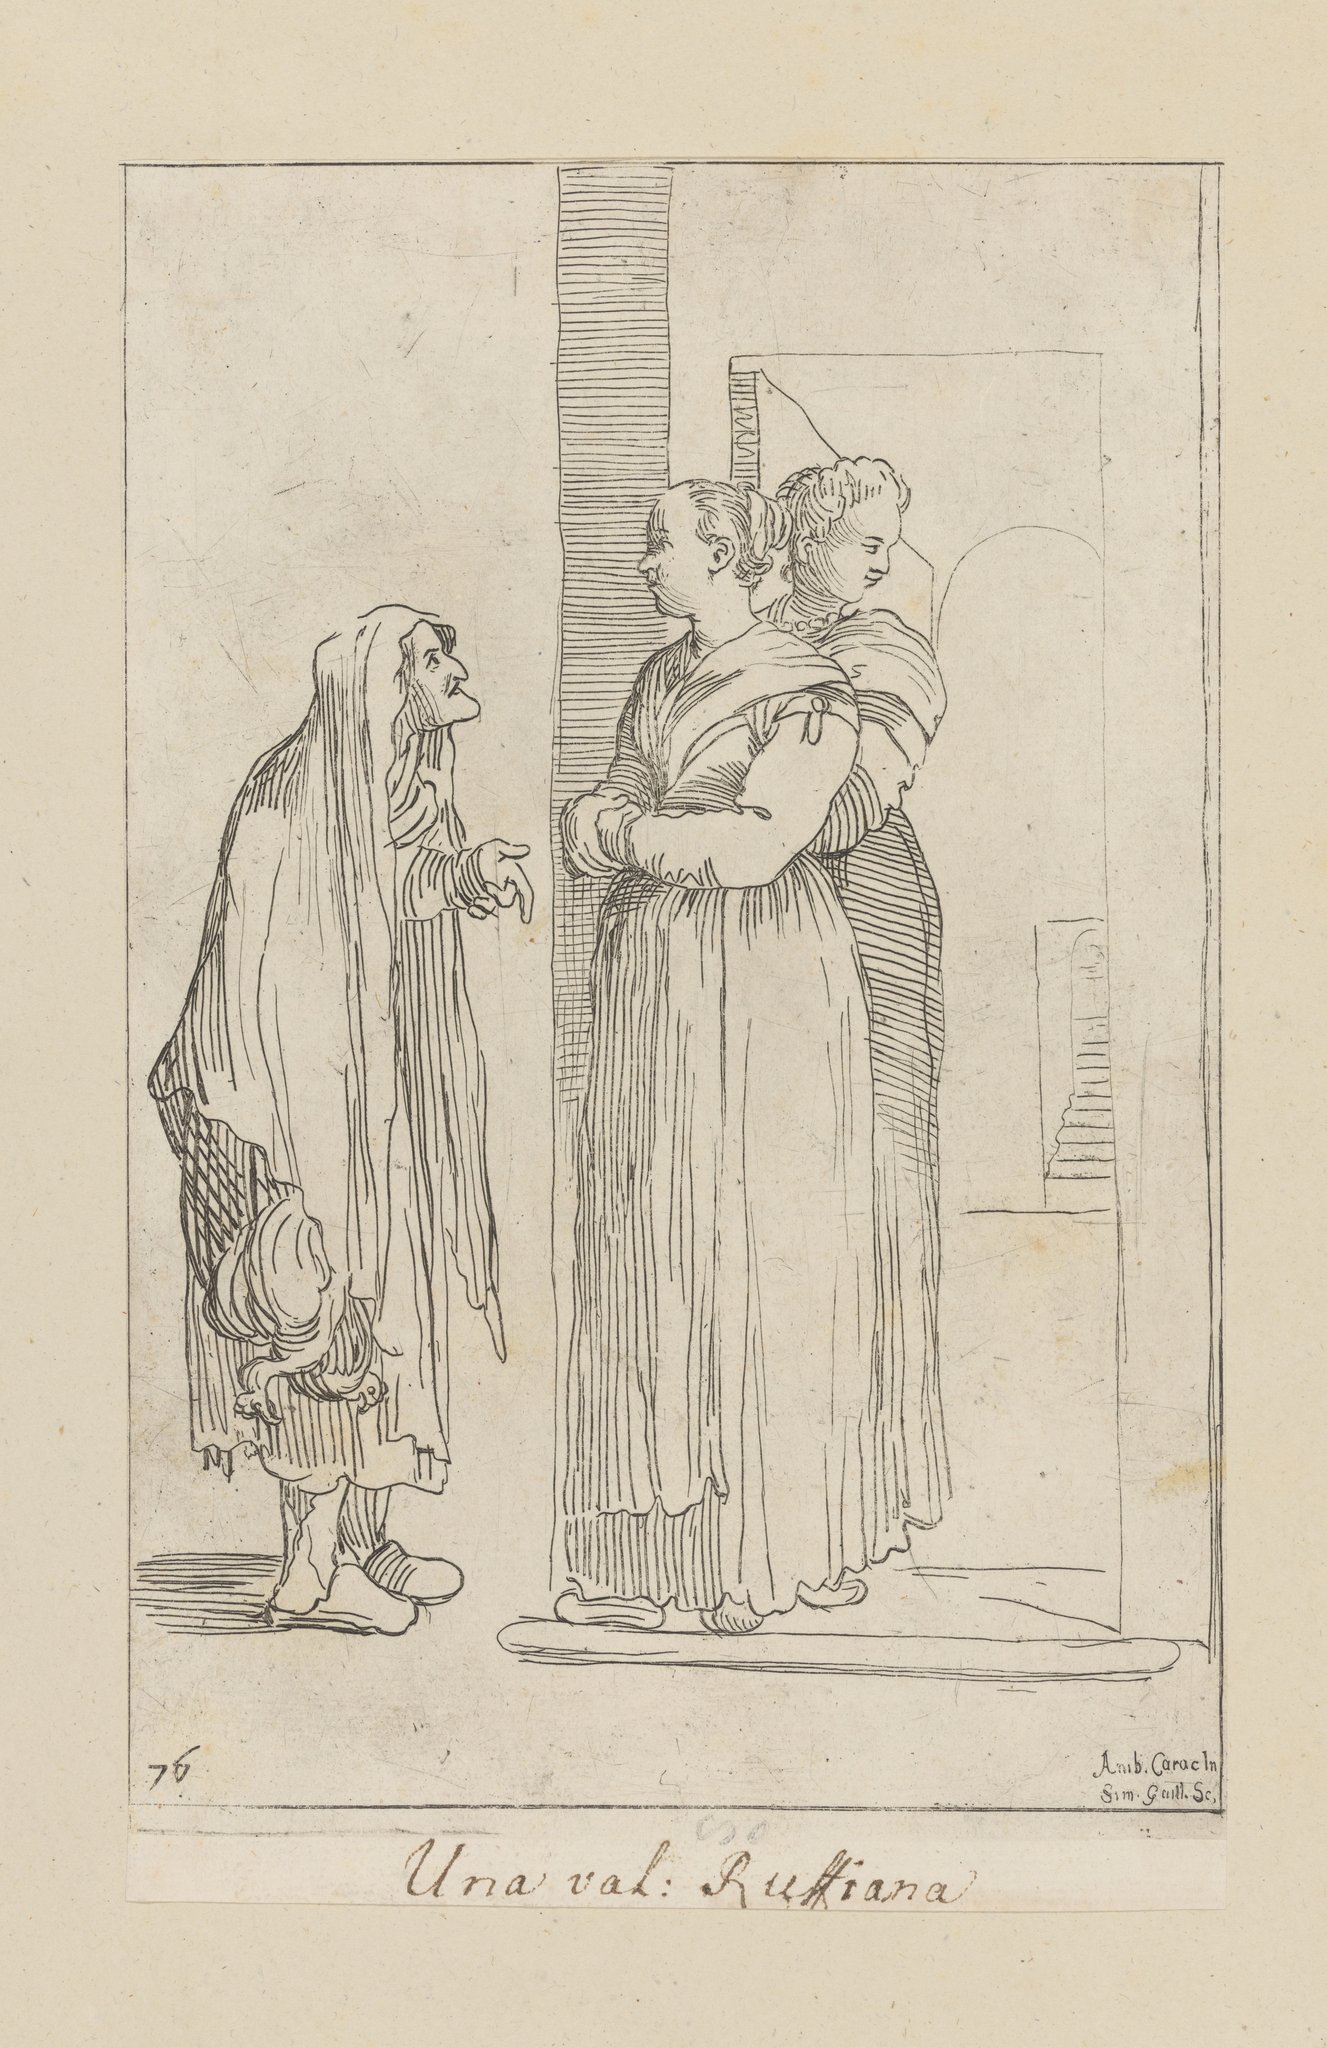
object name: print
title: Plate 76: A procuress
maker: simon guillain ii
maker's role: artist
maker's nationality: french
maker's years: 1618-1718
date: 1646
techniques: etching